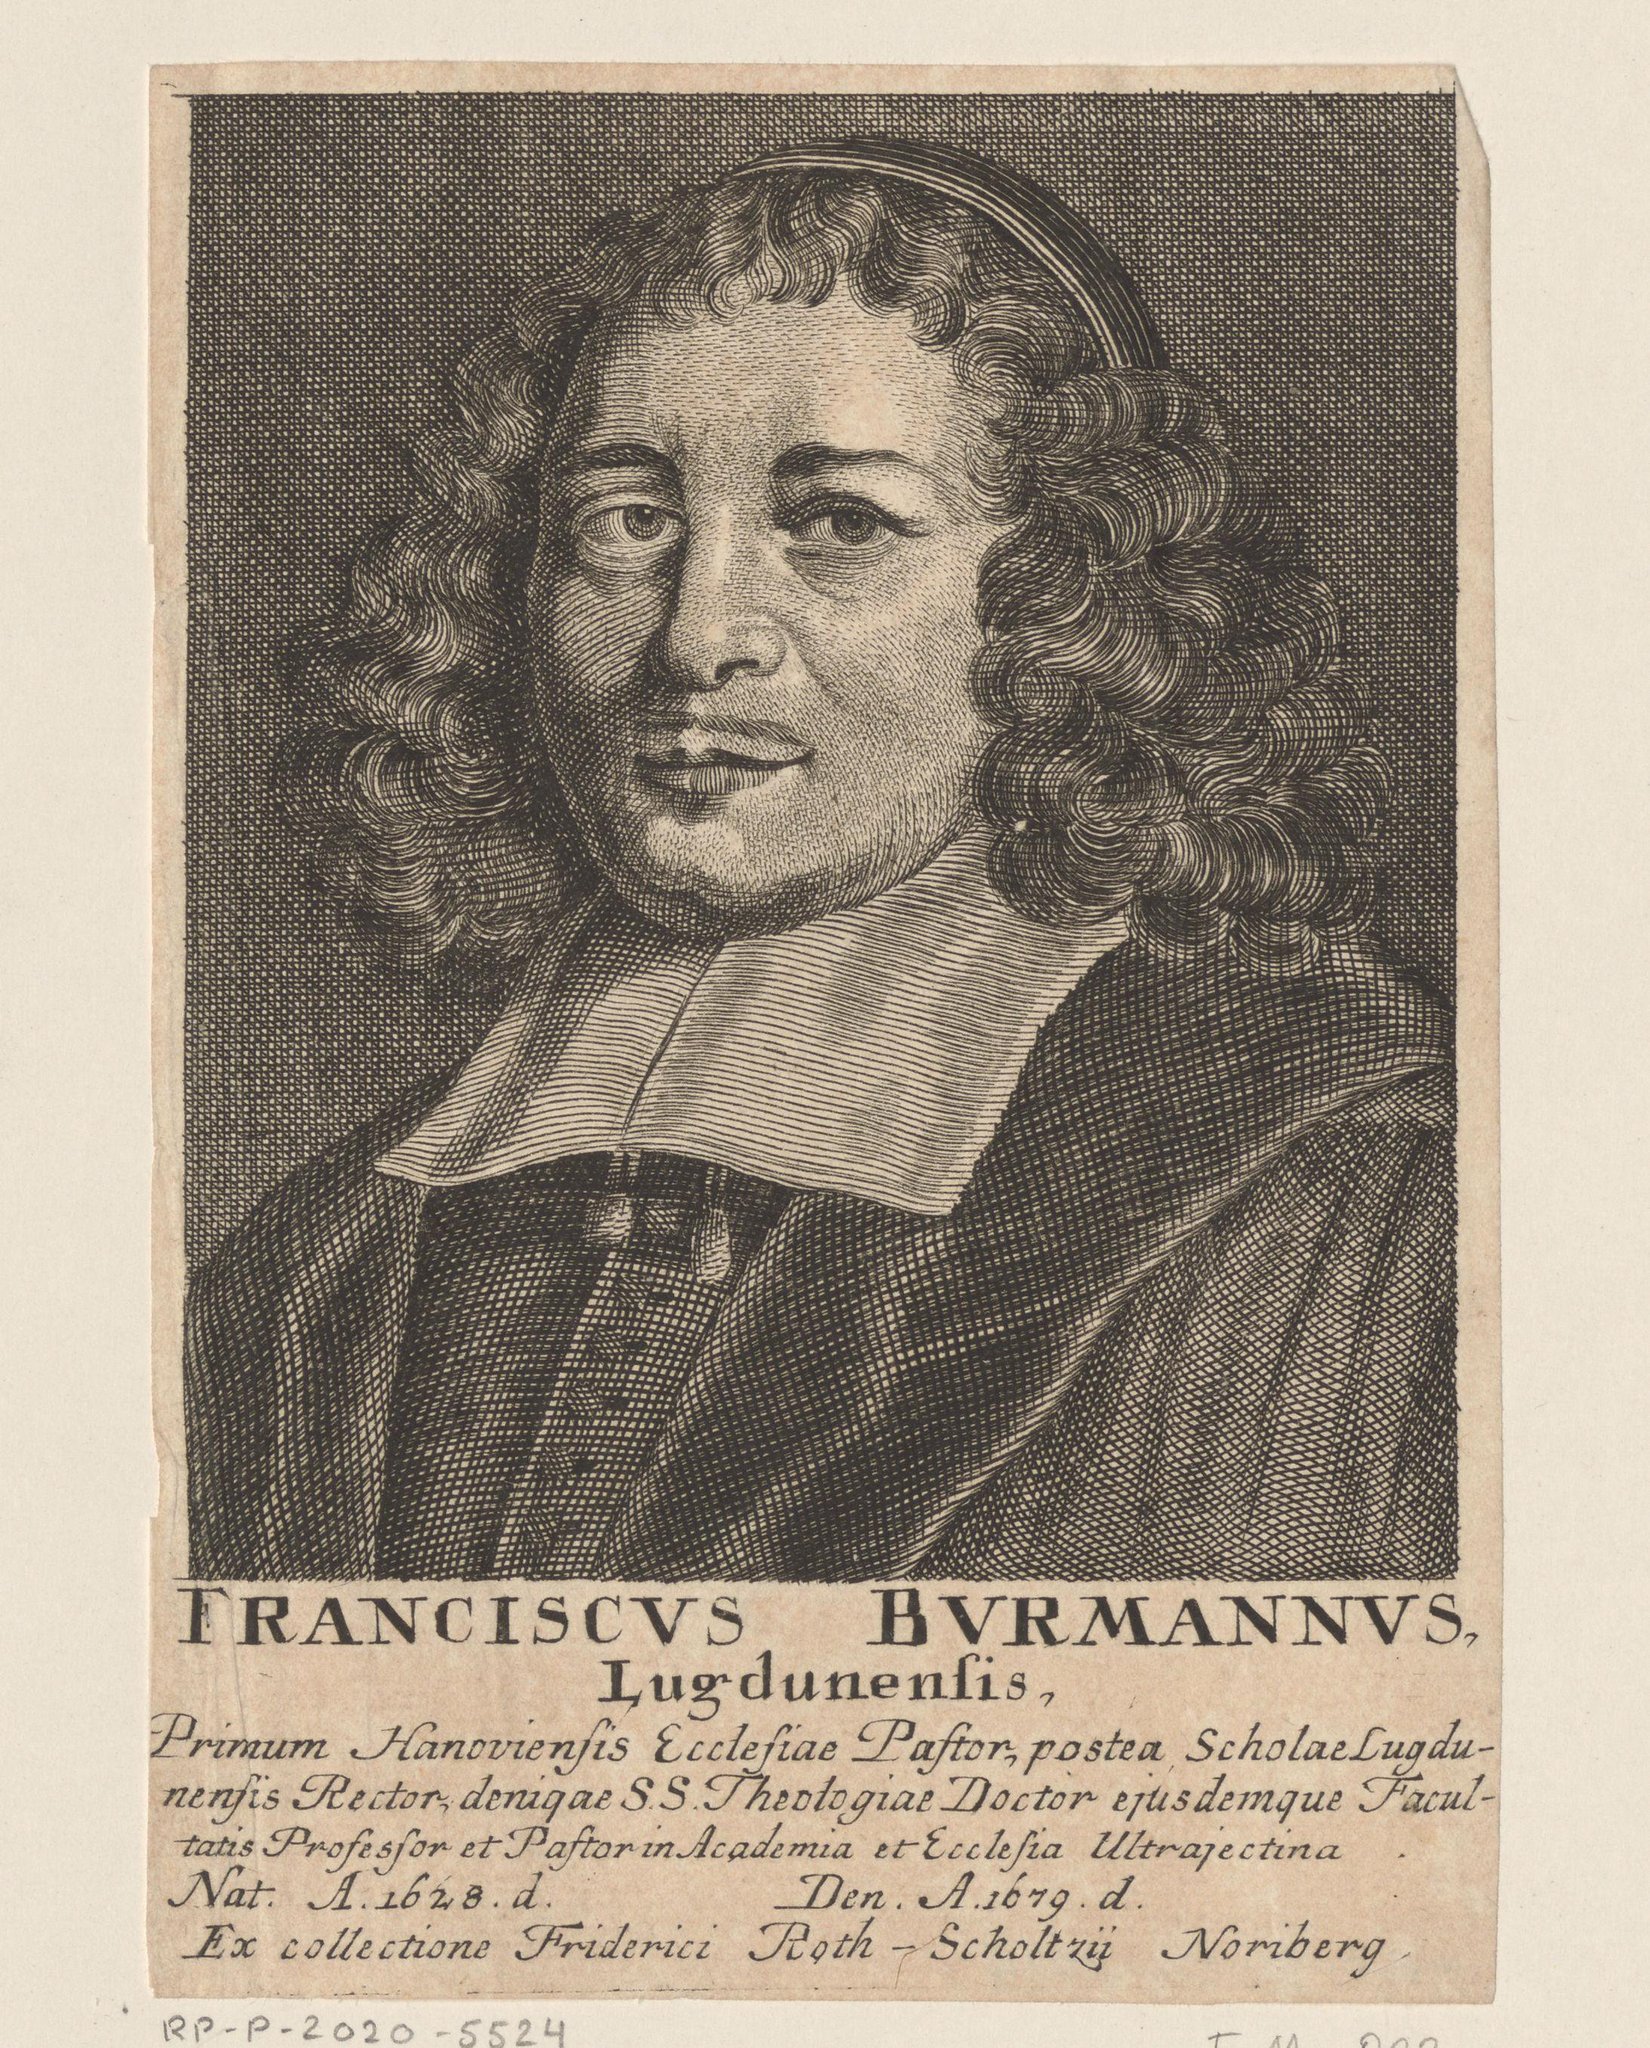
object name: print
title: Portret van Frans Burman (I)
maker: Anonymous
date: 1725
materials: paper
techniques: engraving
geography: nuremberg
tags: utrecht, scholar, philosopher, historical persons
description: Prent waarschijnlijk afkomstig uit één van de series van Friedrich Rothscholtz, uitgegeven in Neurenberg rond 1725.